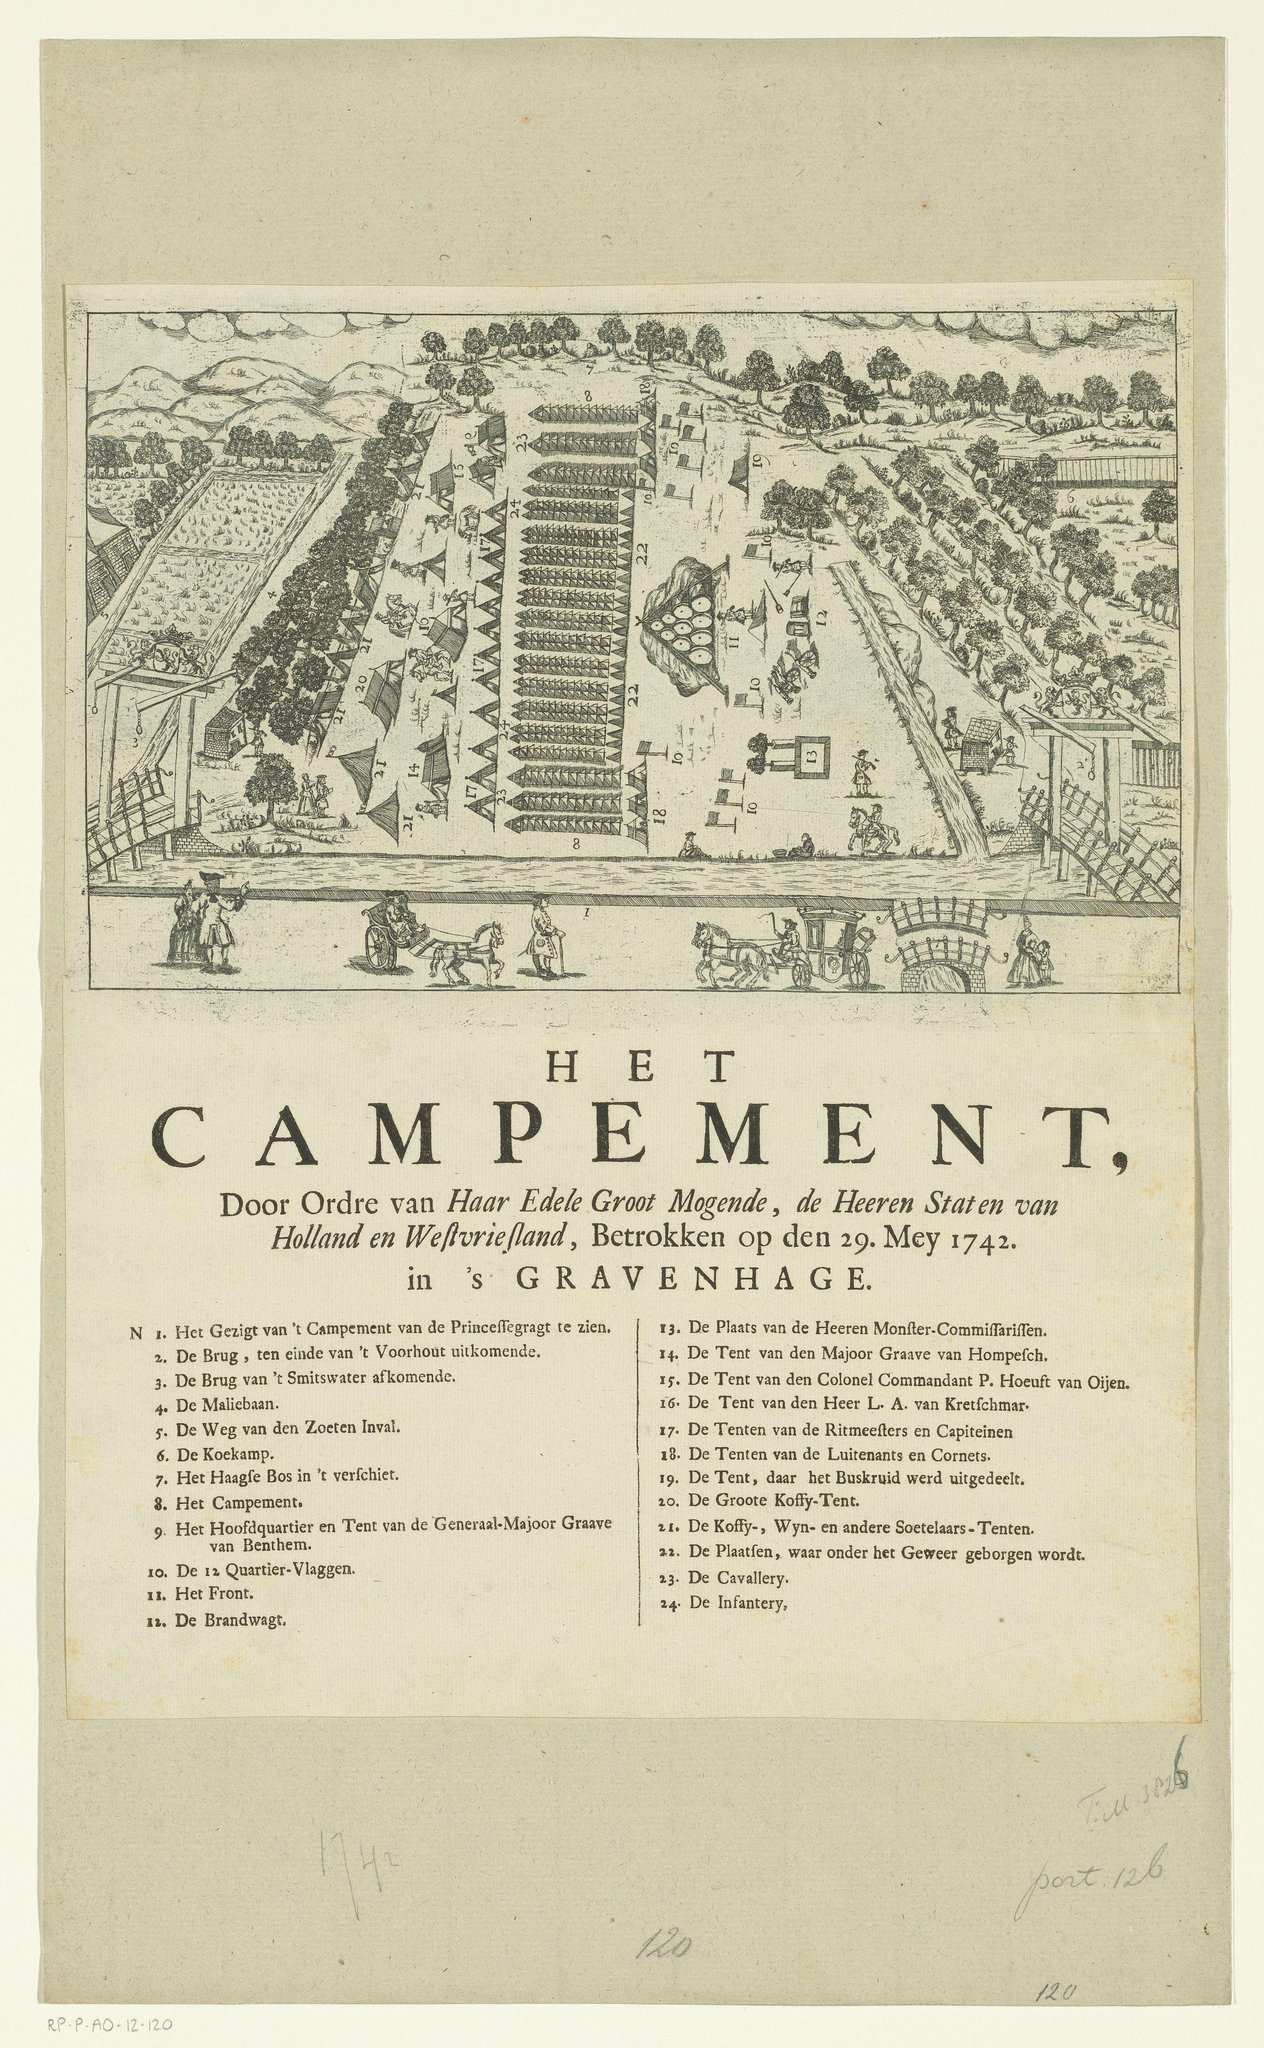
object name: print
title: Het Campement, door ordre van Haar Edele Groot Mogende, de Heeren Staten van Holland en Westvriesland, betrokken op den 29. mey 1742. in 's Gravenhage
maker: Anonymous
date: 1742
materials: paper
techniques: etching, letterpress printing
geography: northern netherlands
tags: (military) camp with tents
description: Gezicht op de grote legeroefening het Kampement te Den Haag, een legerkamp opgeslagen op bevel van de Staten van Holland en West-Friesland in het Haagse Bos bij Den Haag, 29 mei 1742. Met aanzicht en perspectief door elkaar gebruikt. Op het blad onder de plaat de legenda 1-24.